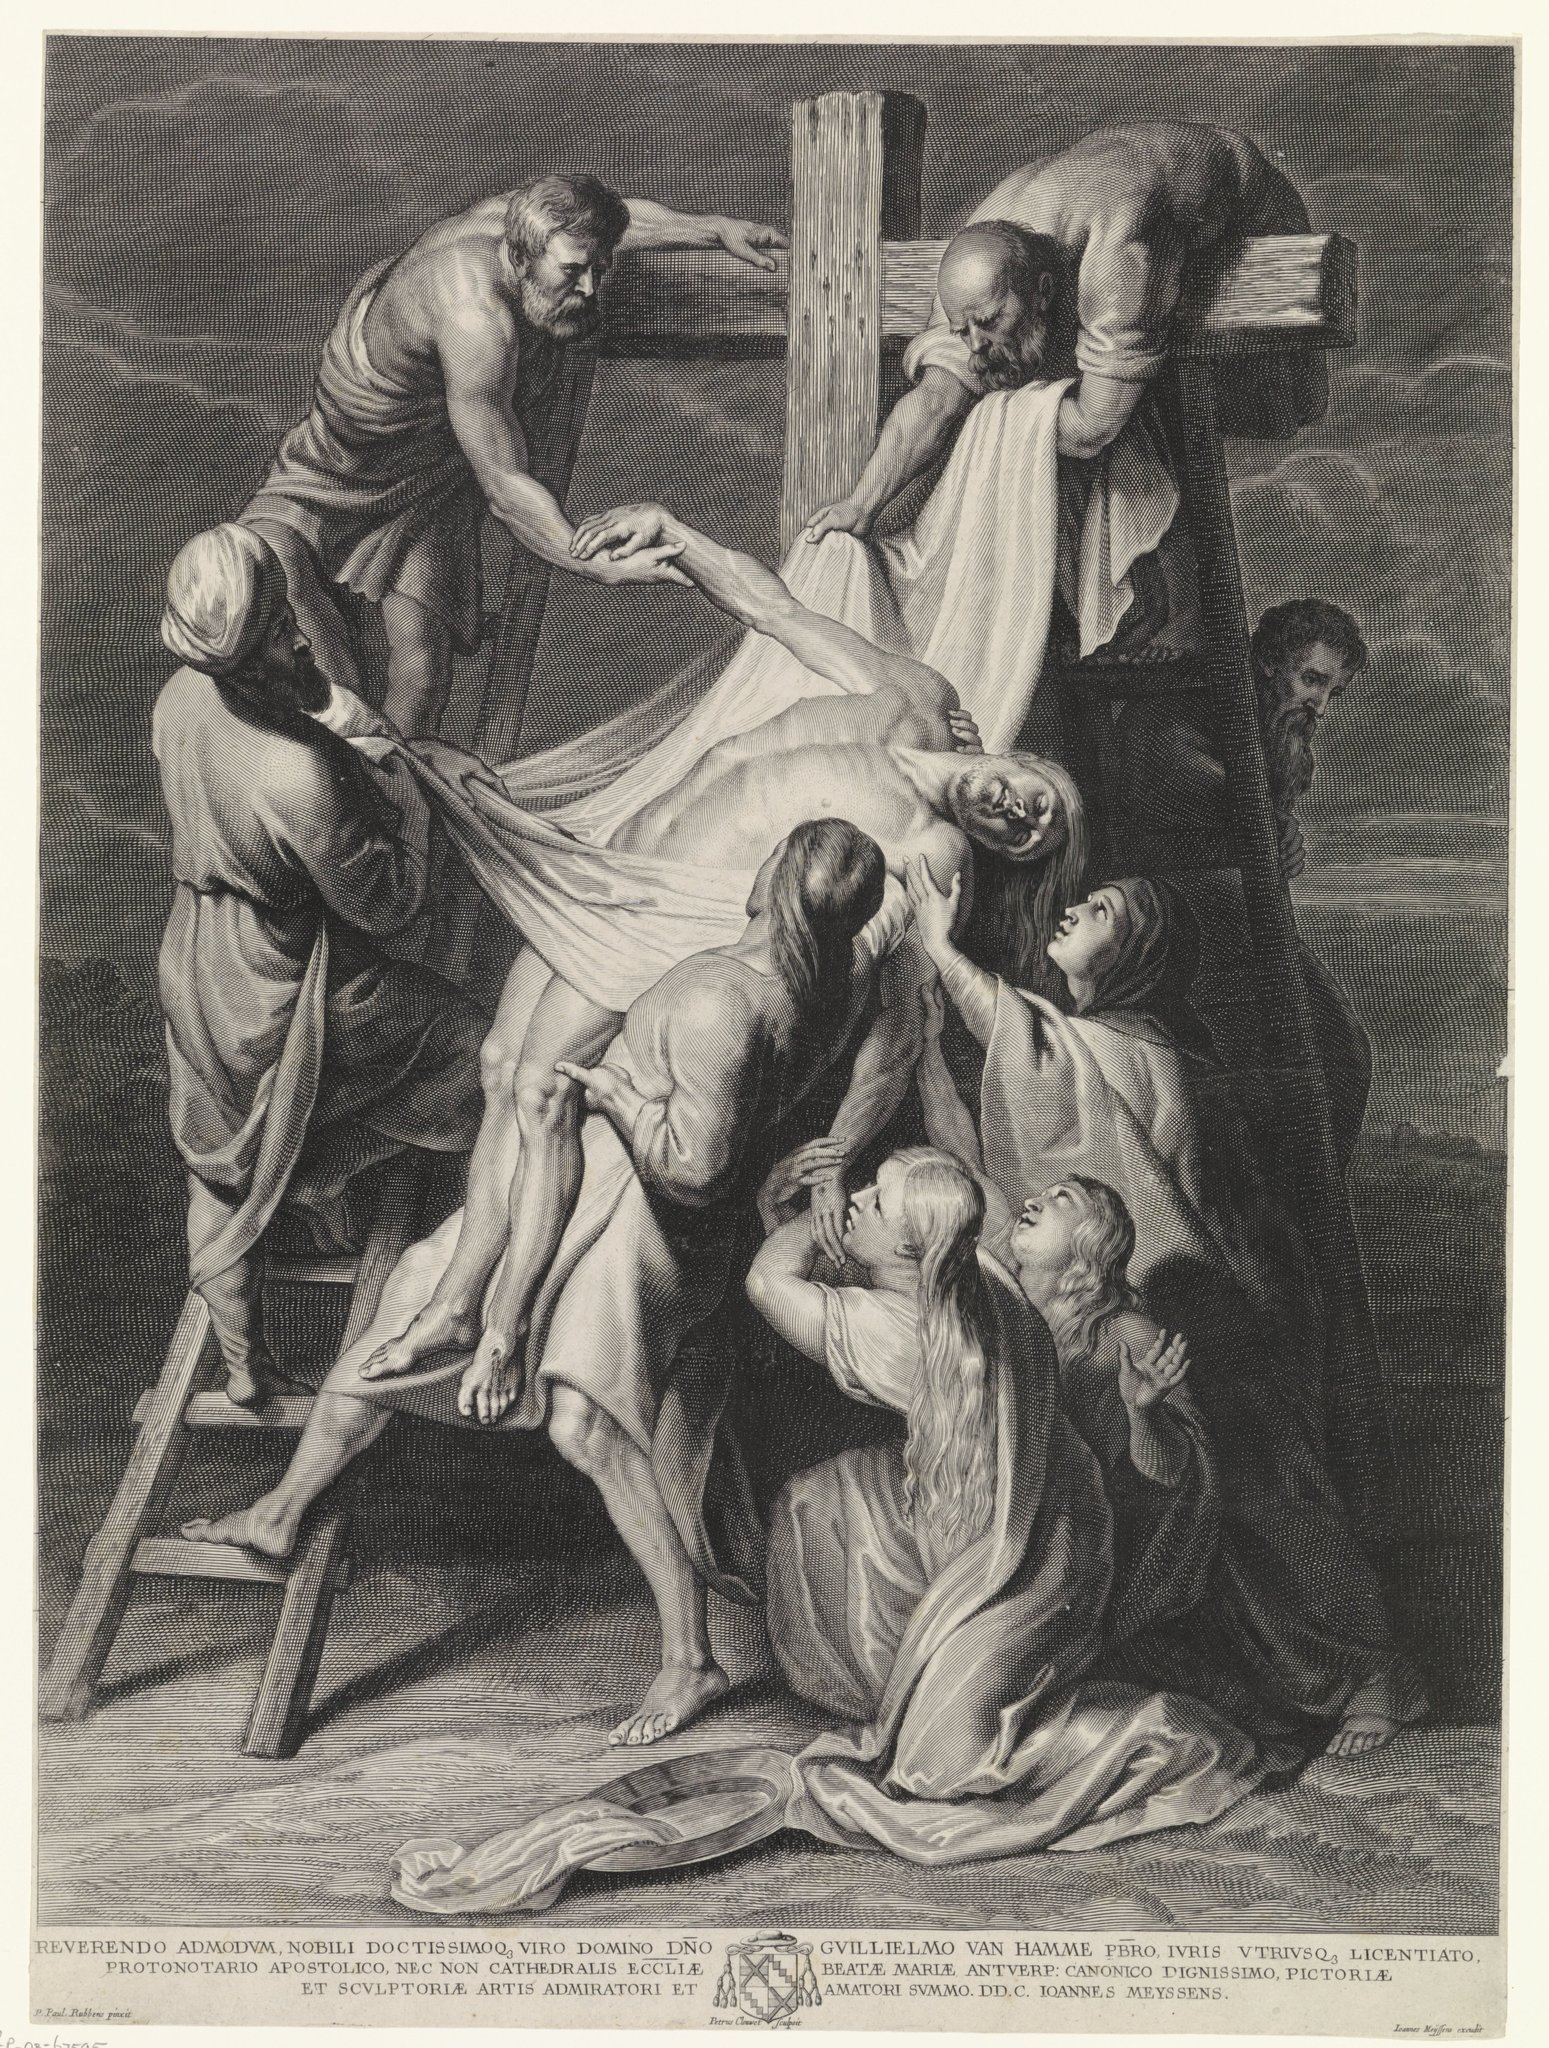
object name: print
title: Kruisafneming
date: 1639-1670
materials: paper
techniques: engraving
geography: antwerp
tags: descent from the cross: christ is taken down from the cross, usually by nicodemus and joseph of arimathaea who are standing on the ladders (both arms of christ detached)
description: Christus wordt door Jozef van Arimatea en Nikodemus van het kruis afgehaald. Johannes neemt het lijk aan, geholpen door de drie Maria's. Twee andere mannen helpen ook. De prent heeft een Latijns onderschrift.